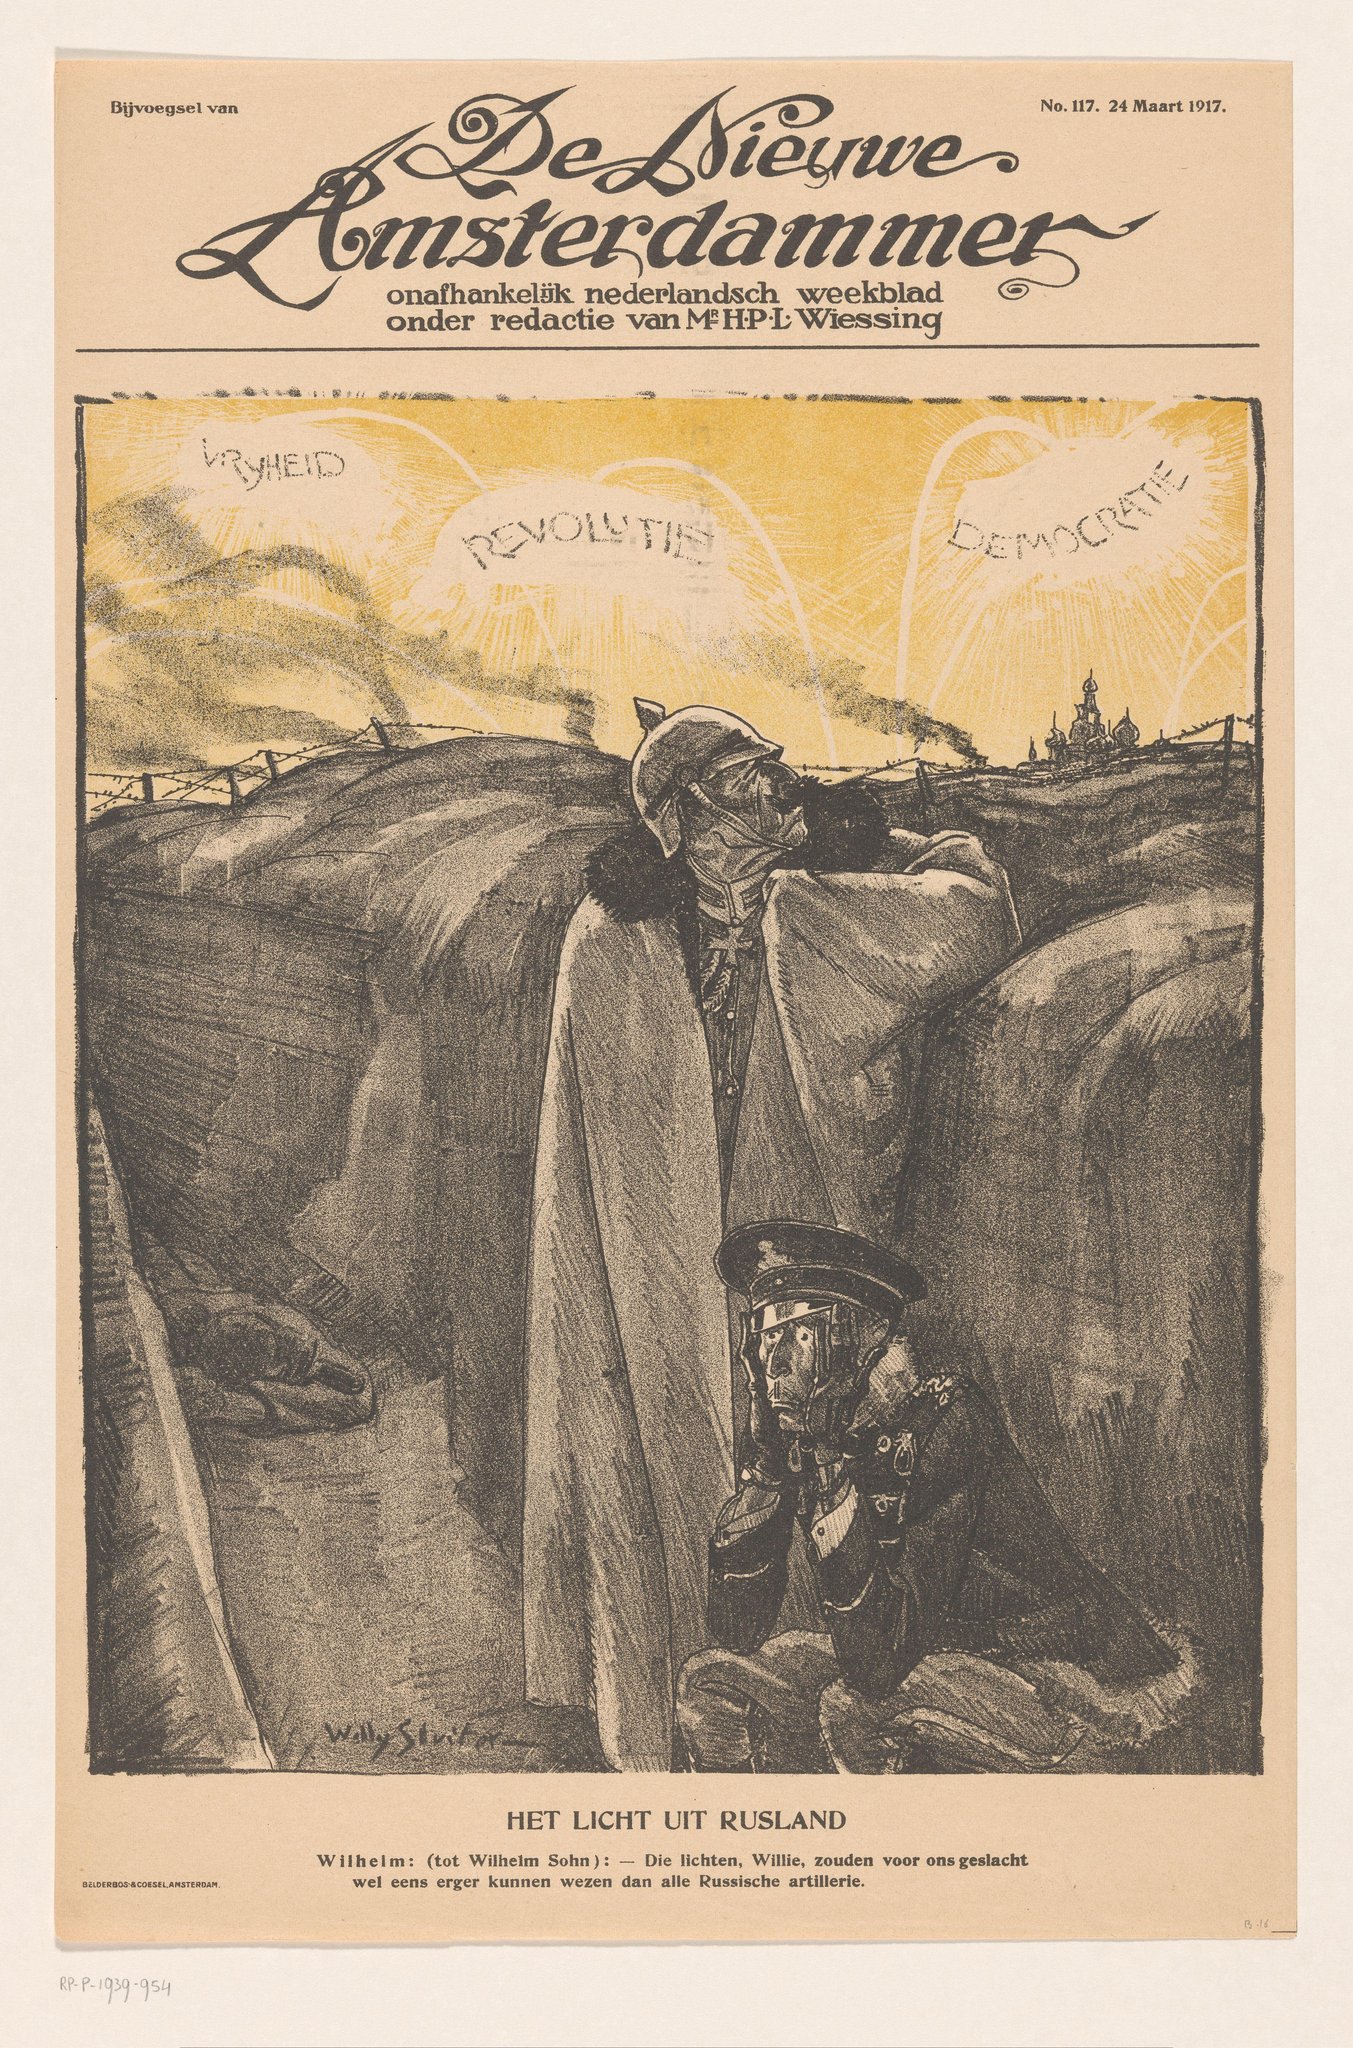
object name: print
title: Het licht uit Rusland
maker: willy sluiter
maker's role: draughtsman, painter, print maker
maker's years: 1873-1949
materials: paper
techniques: letterpress printing, lithograph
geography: amsterdam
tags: wilhelm ii (keizer van duitsland), emperor, trenches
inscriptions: collector's mark: Lugt 2228, collector's mark: Lugt 2760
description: Wilhelm II van Duitsland en zijn zoon staan in een loopgraaf. Aan de horizon de Basiliuskathedraal van Moskou. In de lucht zijn lichtstralen te zien rondom de woorden vrijheid, revolutie en democratie. Onder de voorstelling het opschrift: 'Wilhelm: (tot Wilhelm Sohn): - Die lichten, Willie, zouden voor ons geslacht wel eens erger kunnen wezen dan alle Russische artillerie.'